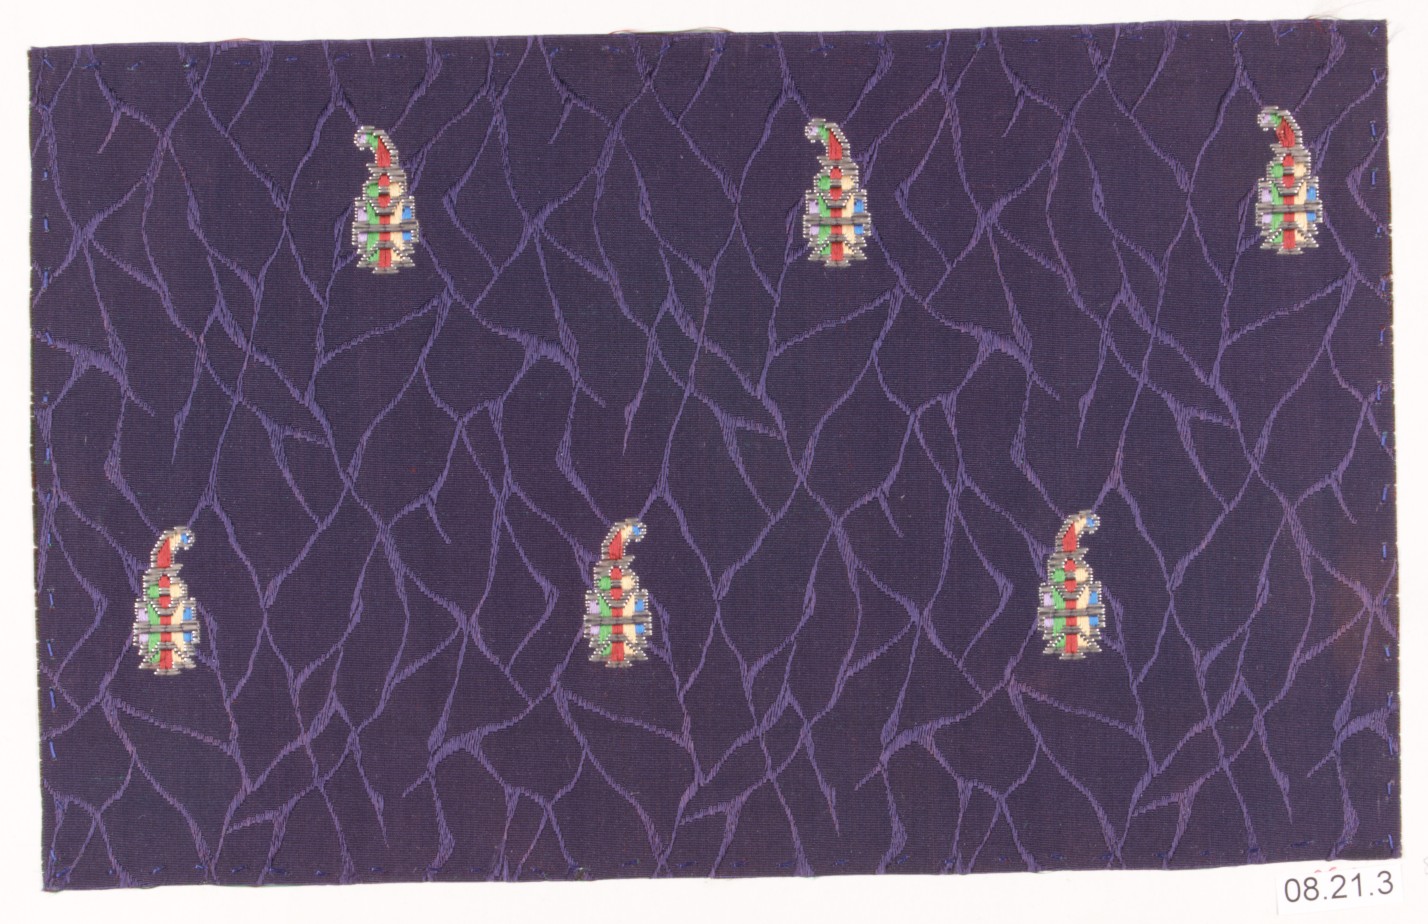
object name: textile sample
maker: Anonymous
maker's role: designer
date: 1900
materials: silk